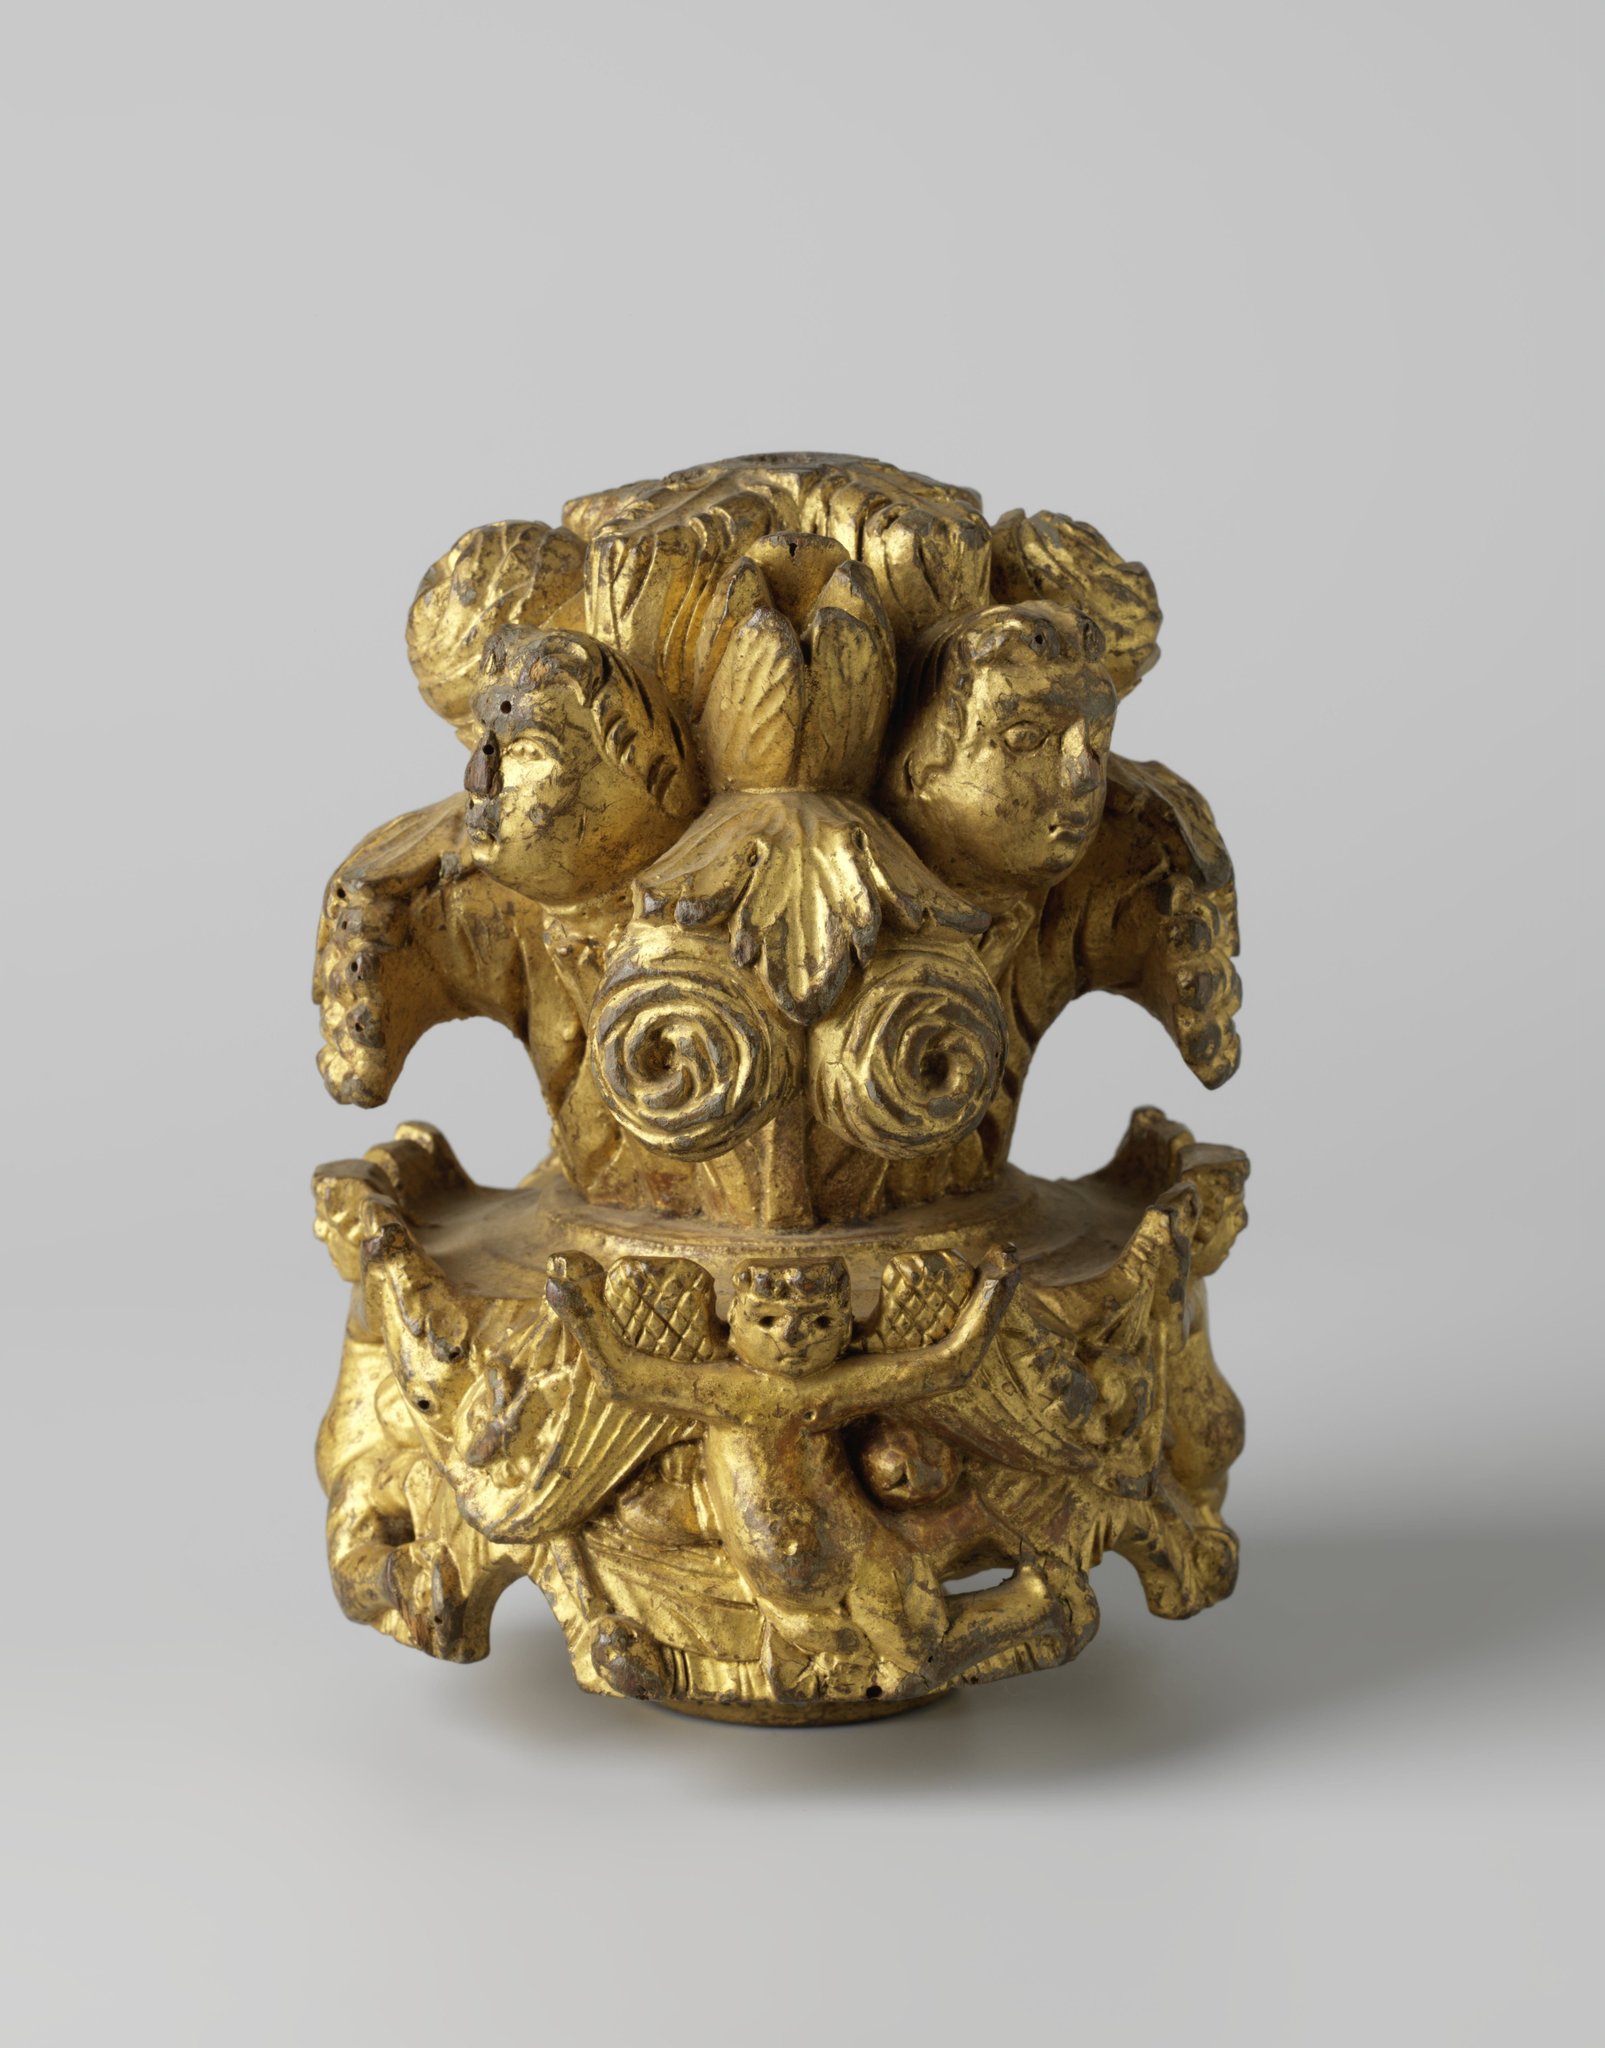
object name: mastwortel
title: Versierde vlaggenstokknop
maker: Anonymous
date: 1600-1800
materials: wood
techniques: cutting, gilding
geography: netherlands